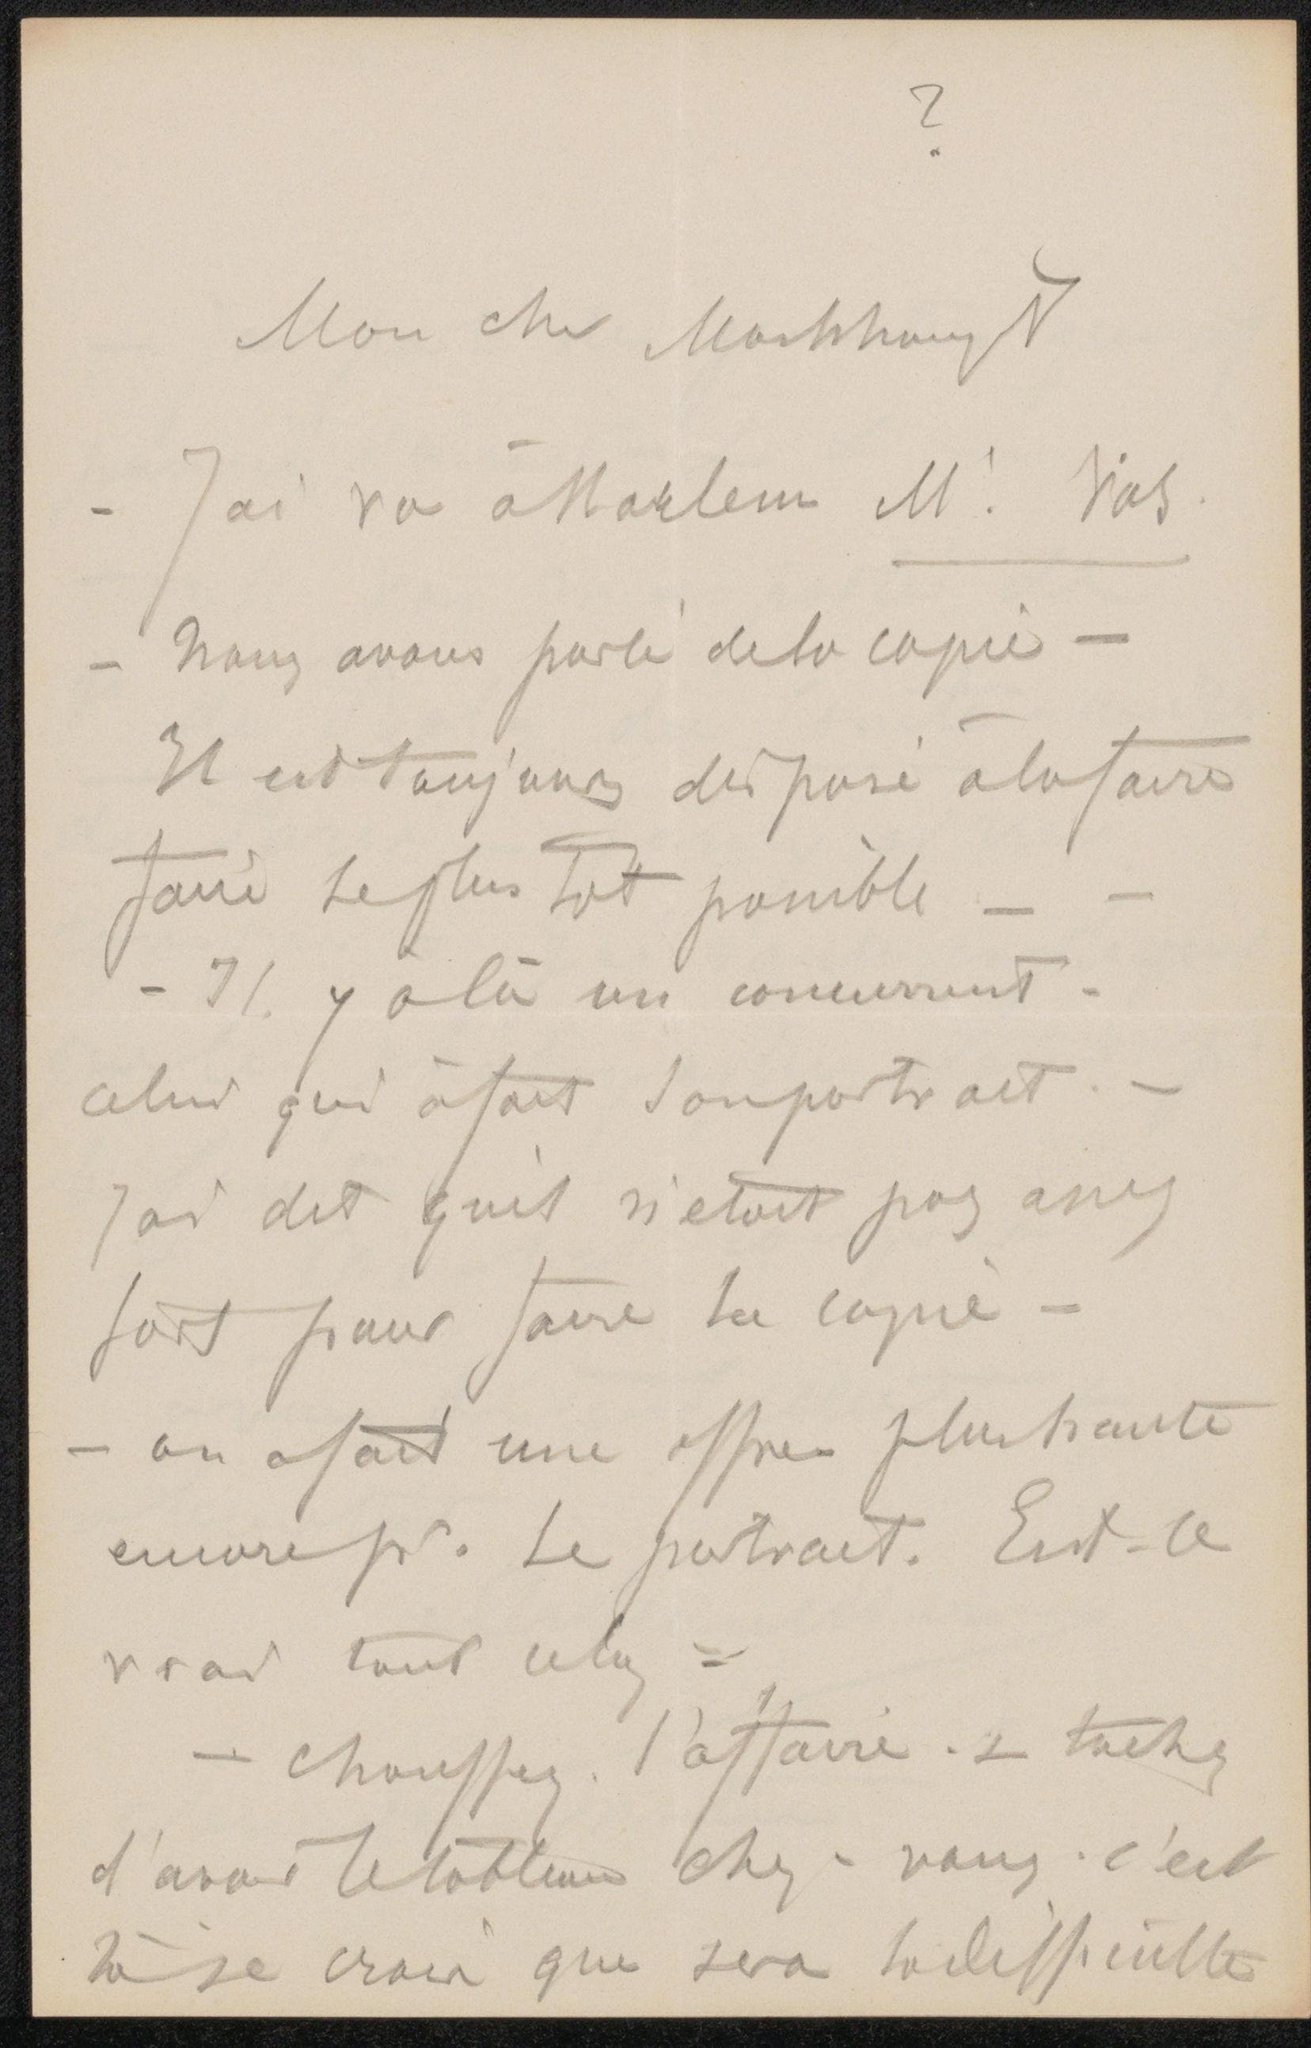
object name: letter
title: Brief aan Jan Hendrik Maschaupt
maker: adolphe mouilleron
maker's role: draughtsman, print maker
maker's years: 1820-1881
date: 1836-1881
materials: paper, pencil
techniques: writing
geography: amsterdam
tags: amsterdam, painter, jan hendrik maschaupt, painting (including book-illumination, miniature-painting), historical persons (portraits and scenes from the life), haarlem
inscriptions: collector's mark: ‘RPK’